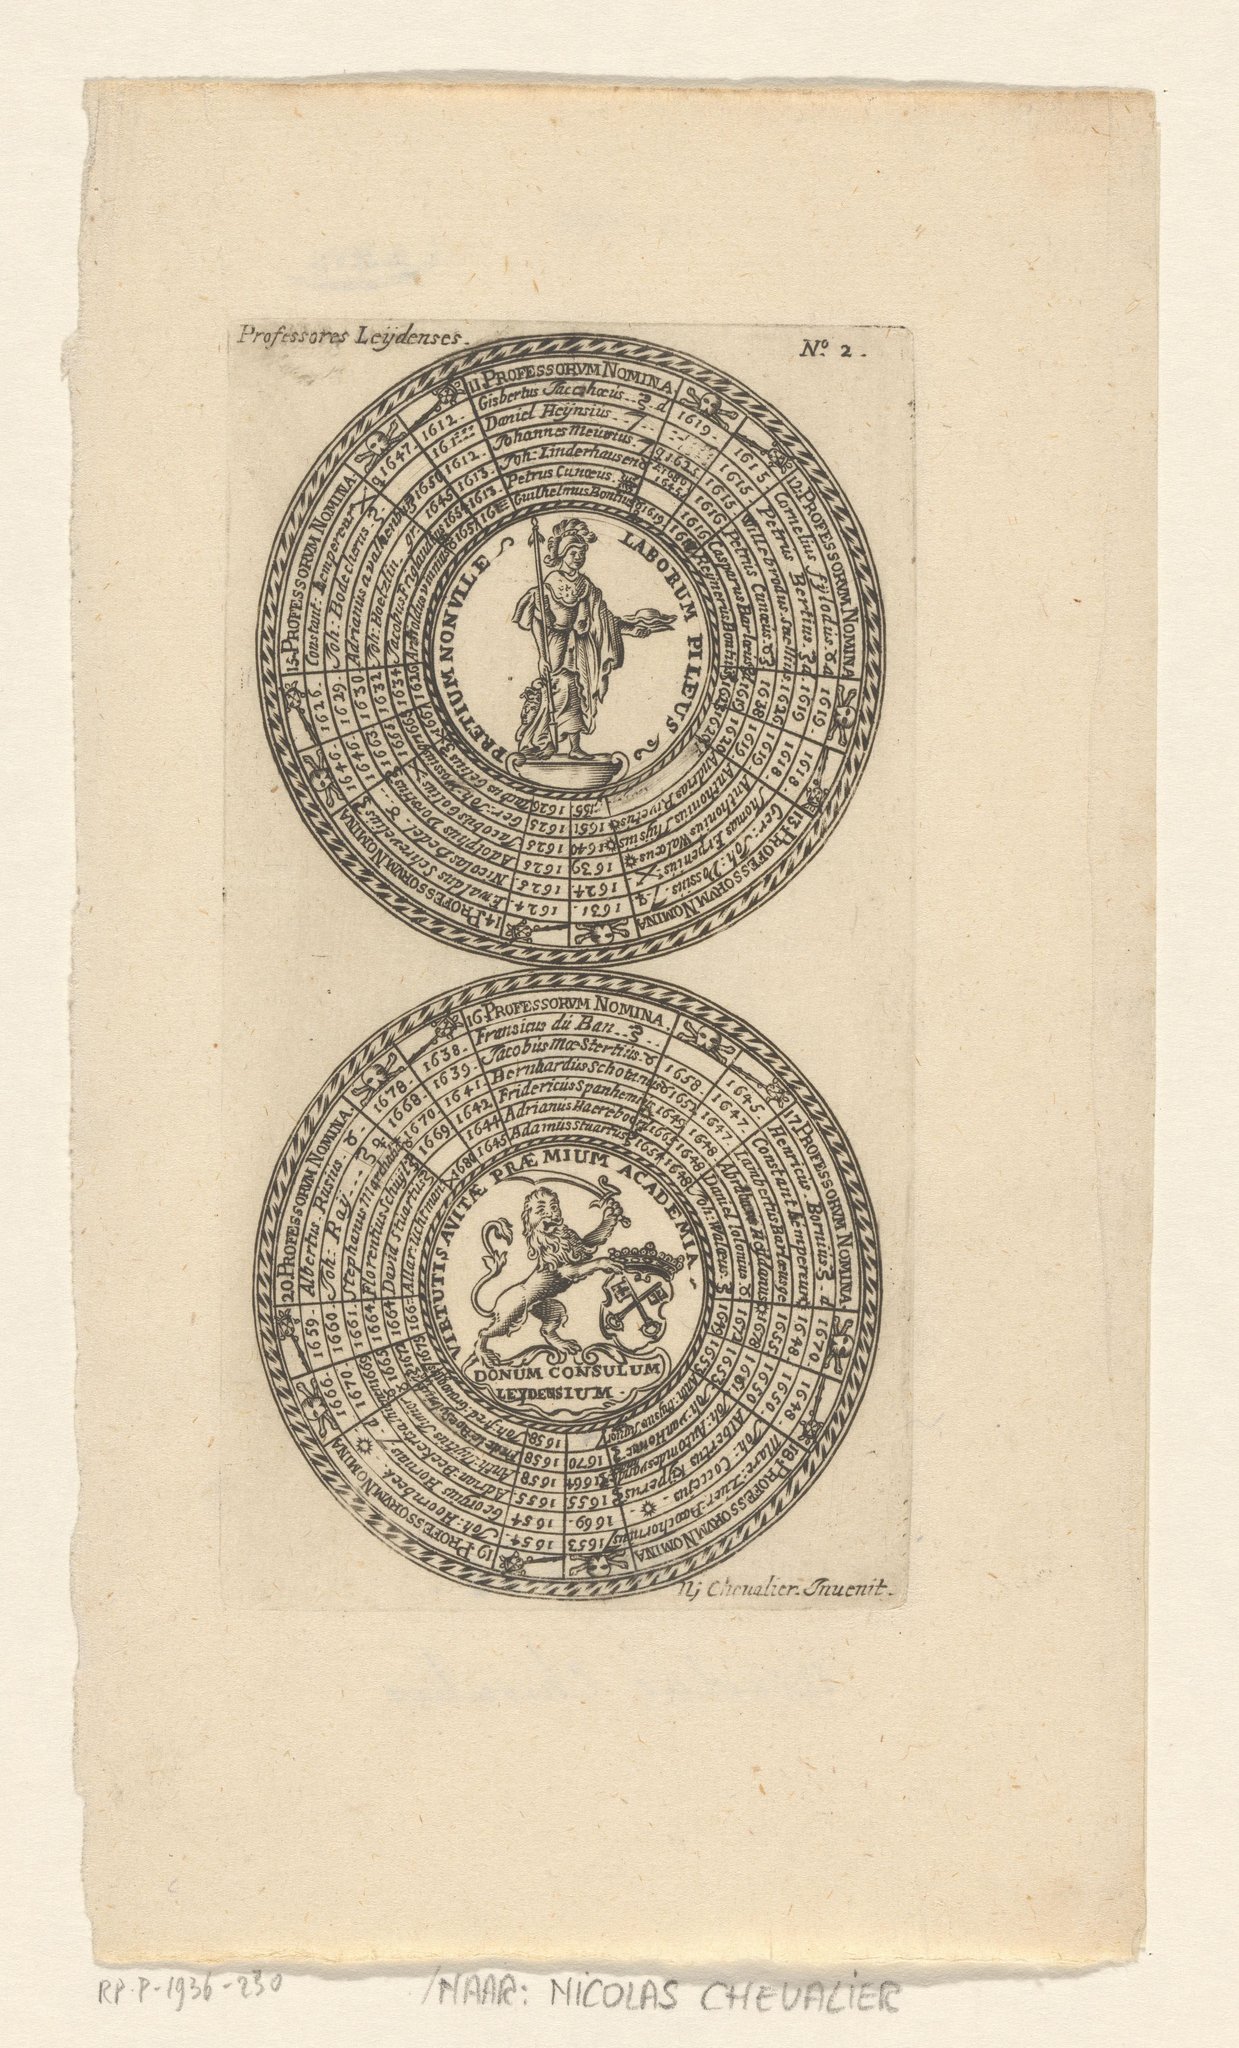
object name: print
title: Zegels van de Universiteit van Leiden, met namen van de hoogleraren en het wapen van de universiteit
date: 1740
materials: paper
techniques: engraving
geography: northern netherlands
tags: insignia, seal ~ university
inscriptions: collector's mark: Lugt 2228, collector's mark: Lugt 2760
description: Prent waarschijnlijk uit: Chronologische Tafelen, In zes en dertig Kopere Platen verbeeld, zo van Keizers, Koningen, Prinsen (...). Amsterdam: Pieter Bastiaansz., 1740.